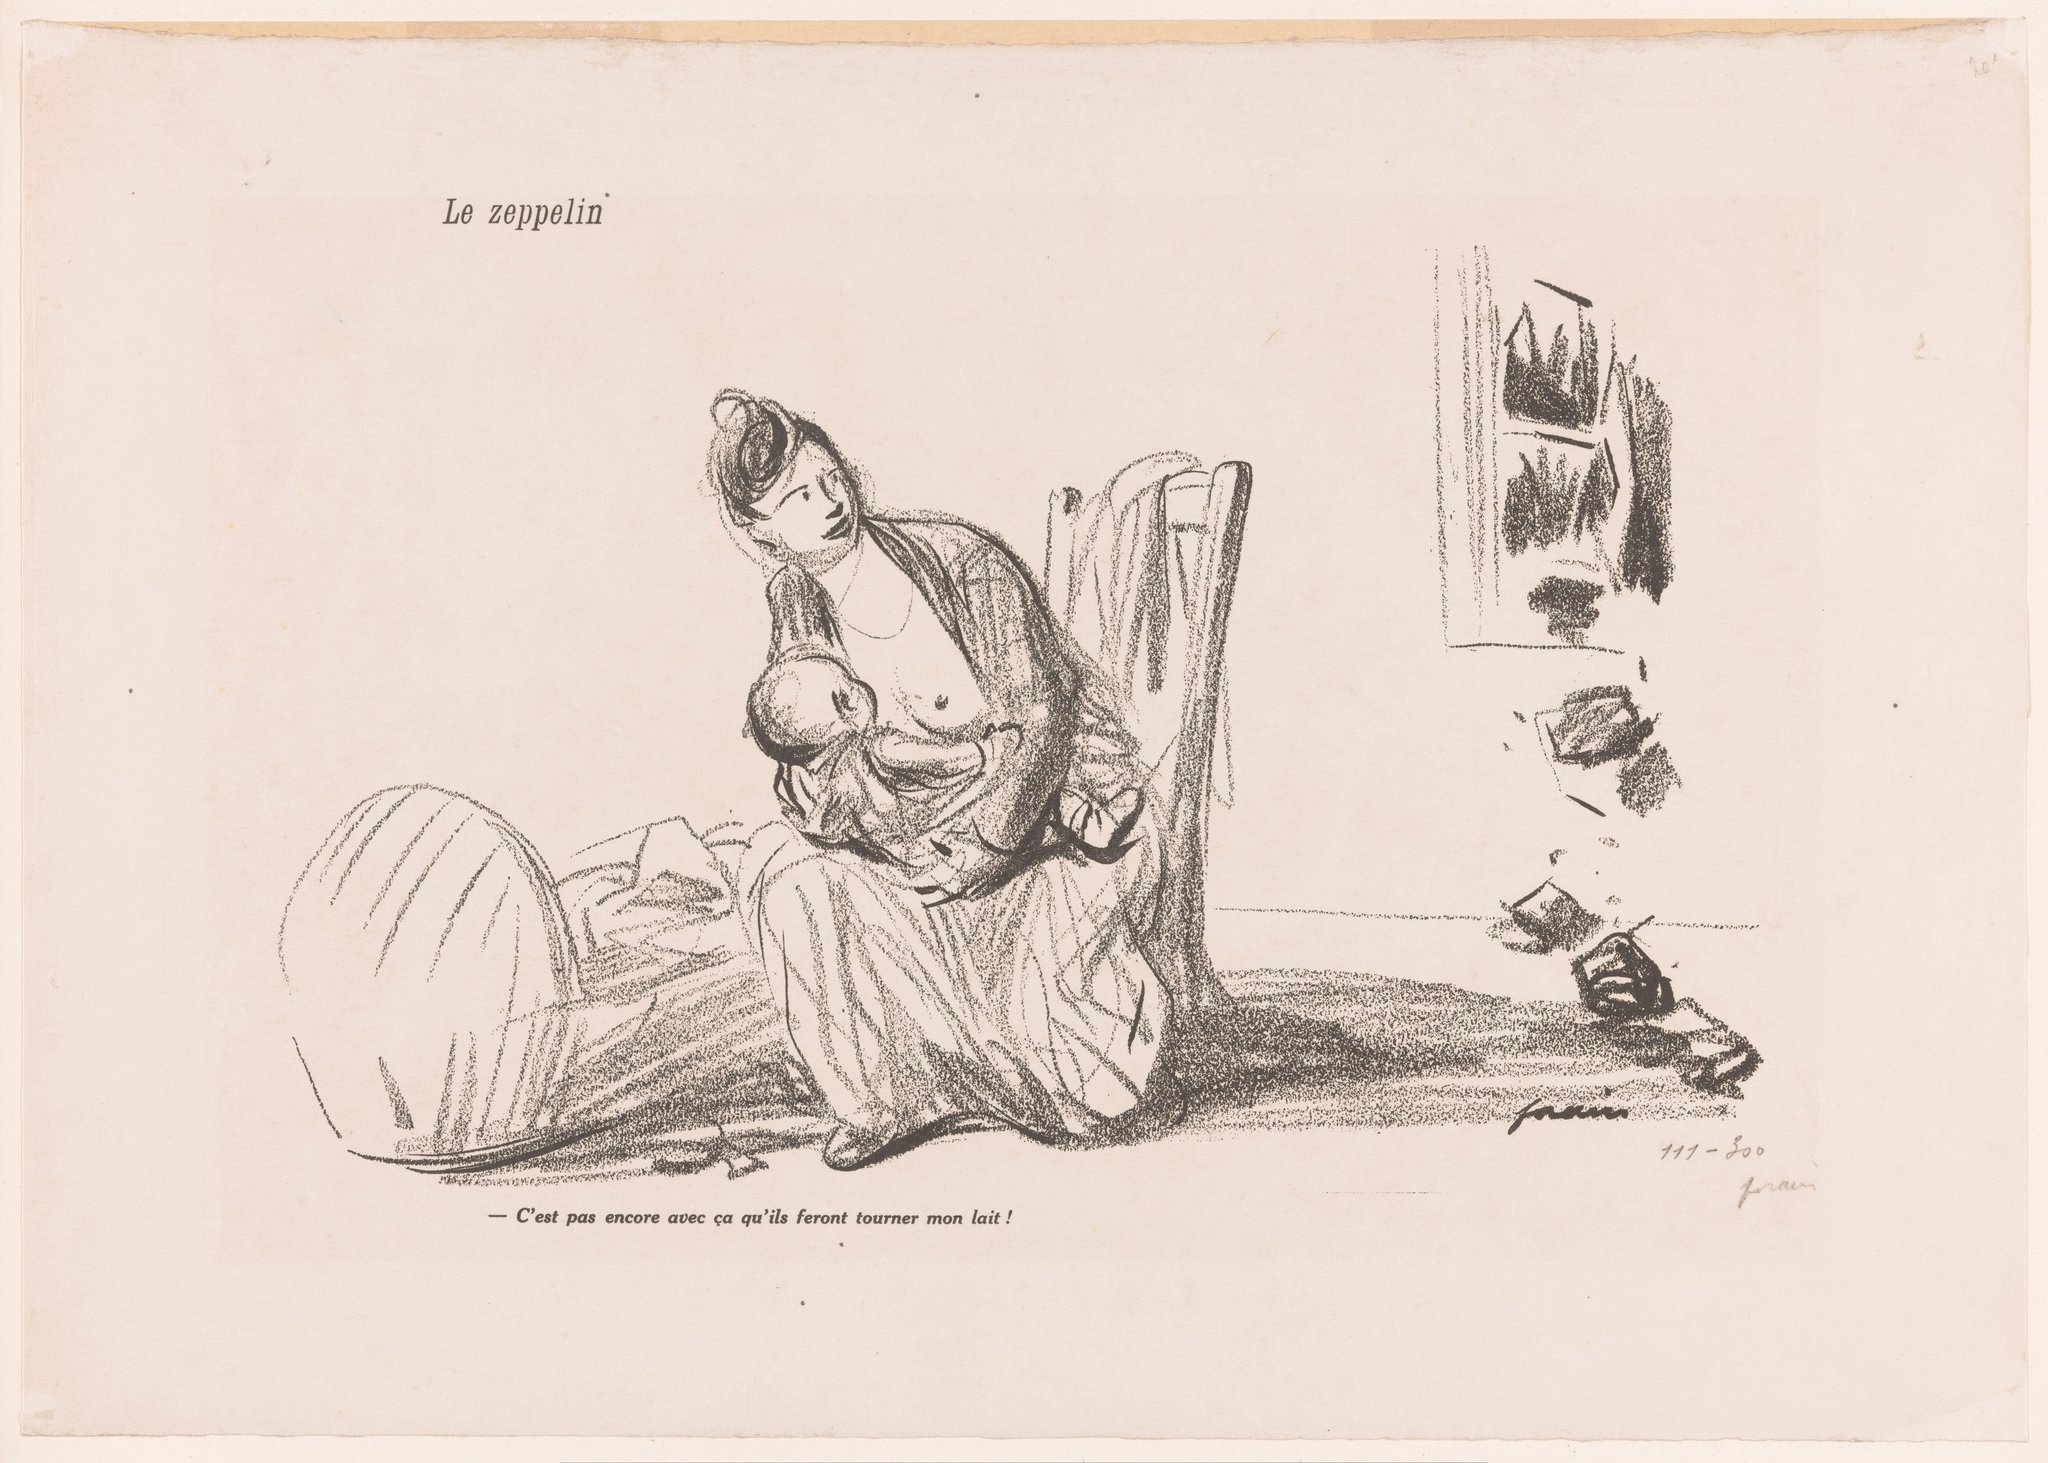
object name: print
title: Le zeppelin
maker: jean-louis forain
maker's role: painter, print maker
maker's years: 1852-1931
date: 1916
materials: paper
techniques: lithograph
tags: civilians during bombardment, nursing, suckling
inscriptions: collector's mark: Lugt 2228a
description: Prent gebruikt voor: Le Figaro, 2 februari 1916.